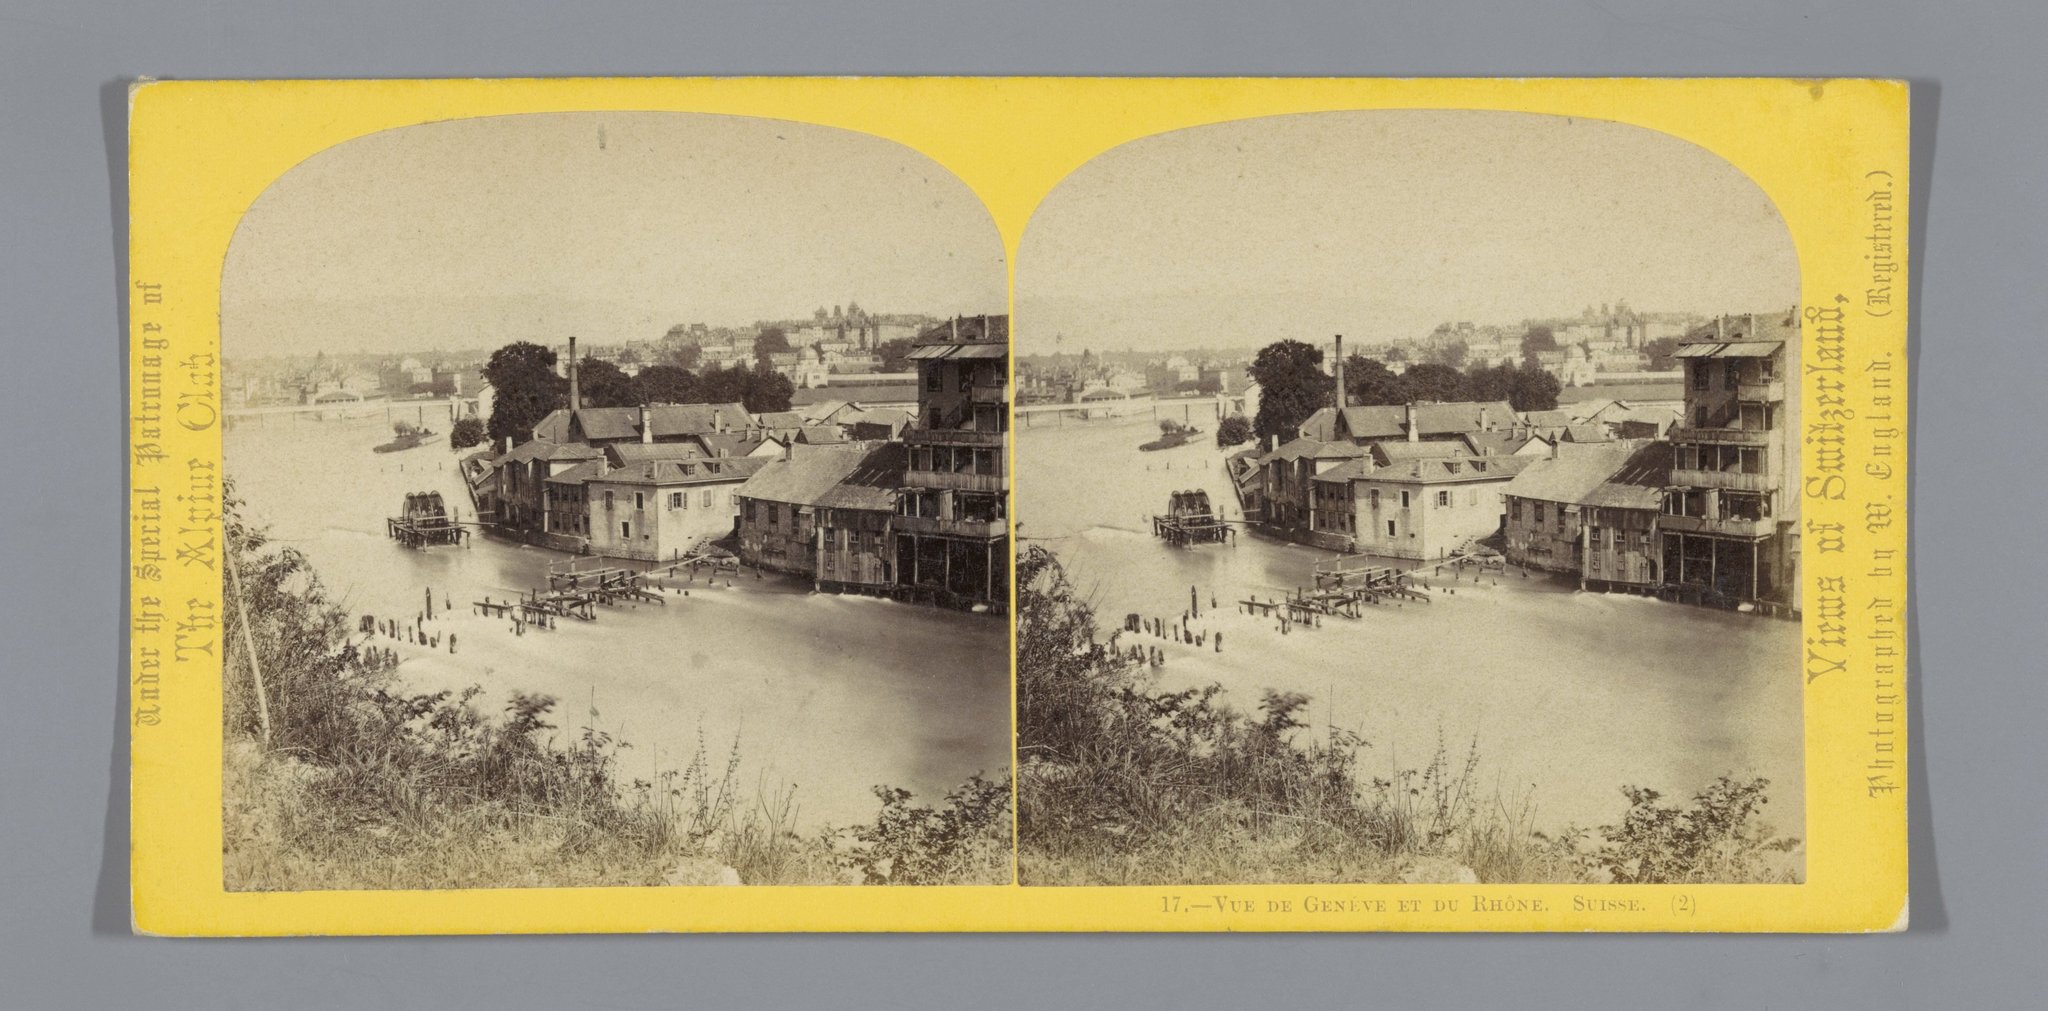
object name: stereograph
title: Vue de Genéve et du Rhône. Suisse. (2)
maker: william england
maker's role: fotograaf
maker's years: 1816-1896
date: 1850-1880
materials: cardboard, photographic support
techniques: albumen print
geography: geneva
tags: city-view in general; 'veduta', river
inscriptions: number: ‘17.’, inscription: ‘Views of Switzerland, photographed by W. England. (Registered) Under the Special Patronage of the Alpine Club.’